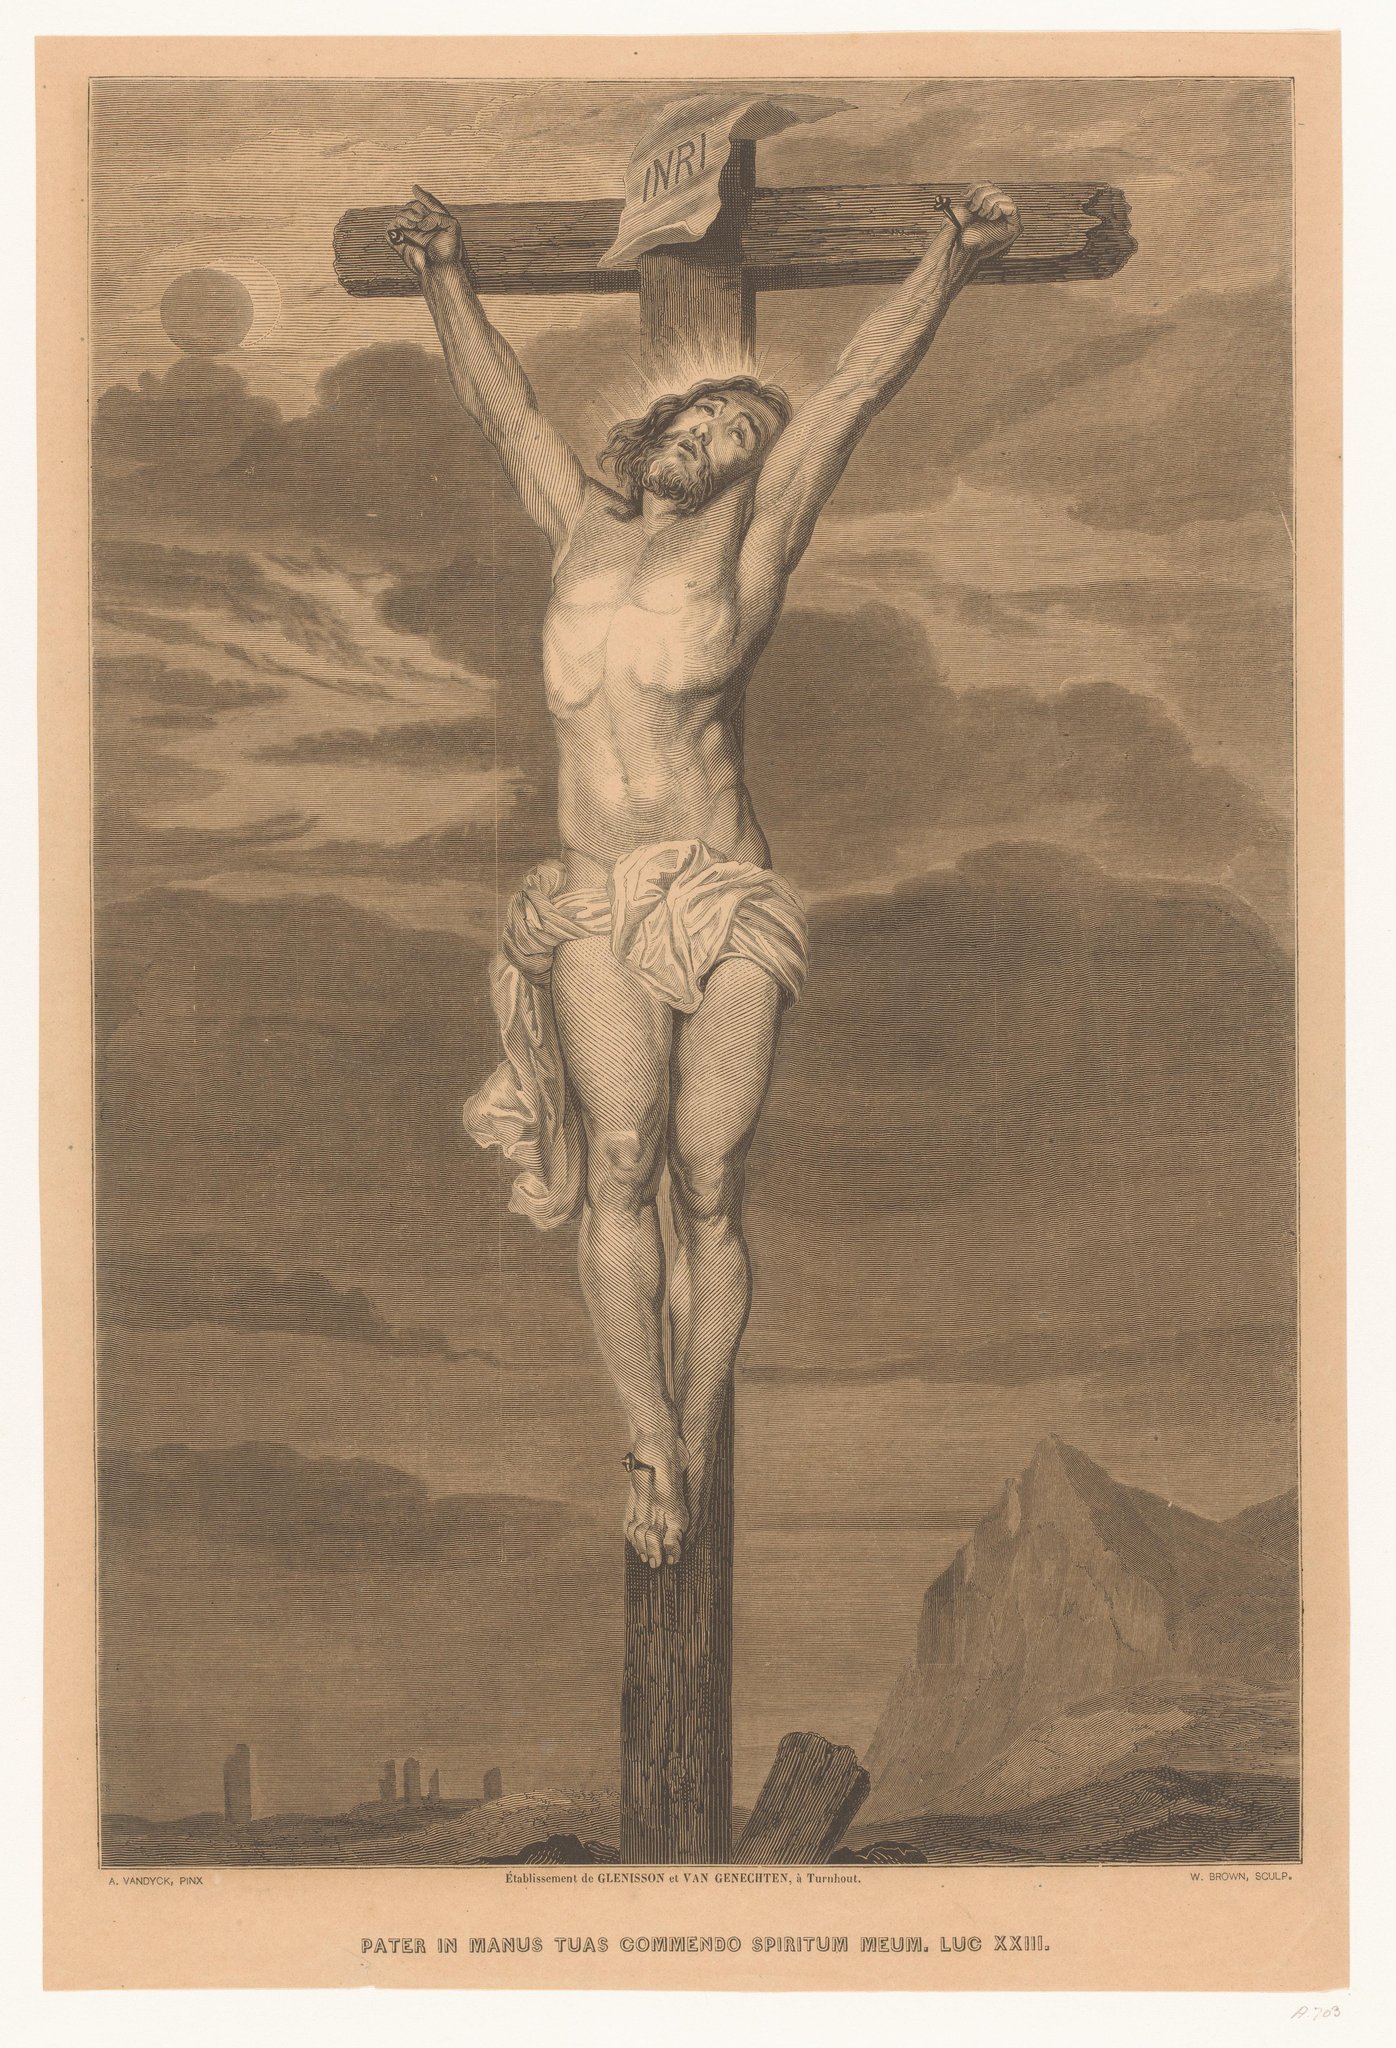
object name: print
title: Pater in manus tuas commendo spiritum meum. Luc XXIII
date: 1833-1856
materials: paper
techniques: engraving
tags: the superscription: i(esus) n(azarenus) r(ex) i(udaeorum) ~ christ's crucifixion, comprehensive representations of the events on golgotha during christ's hanging on the cross, no particular event emphasized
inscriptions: collector's mark: Lugt 2228